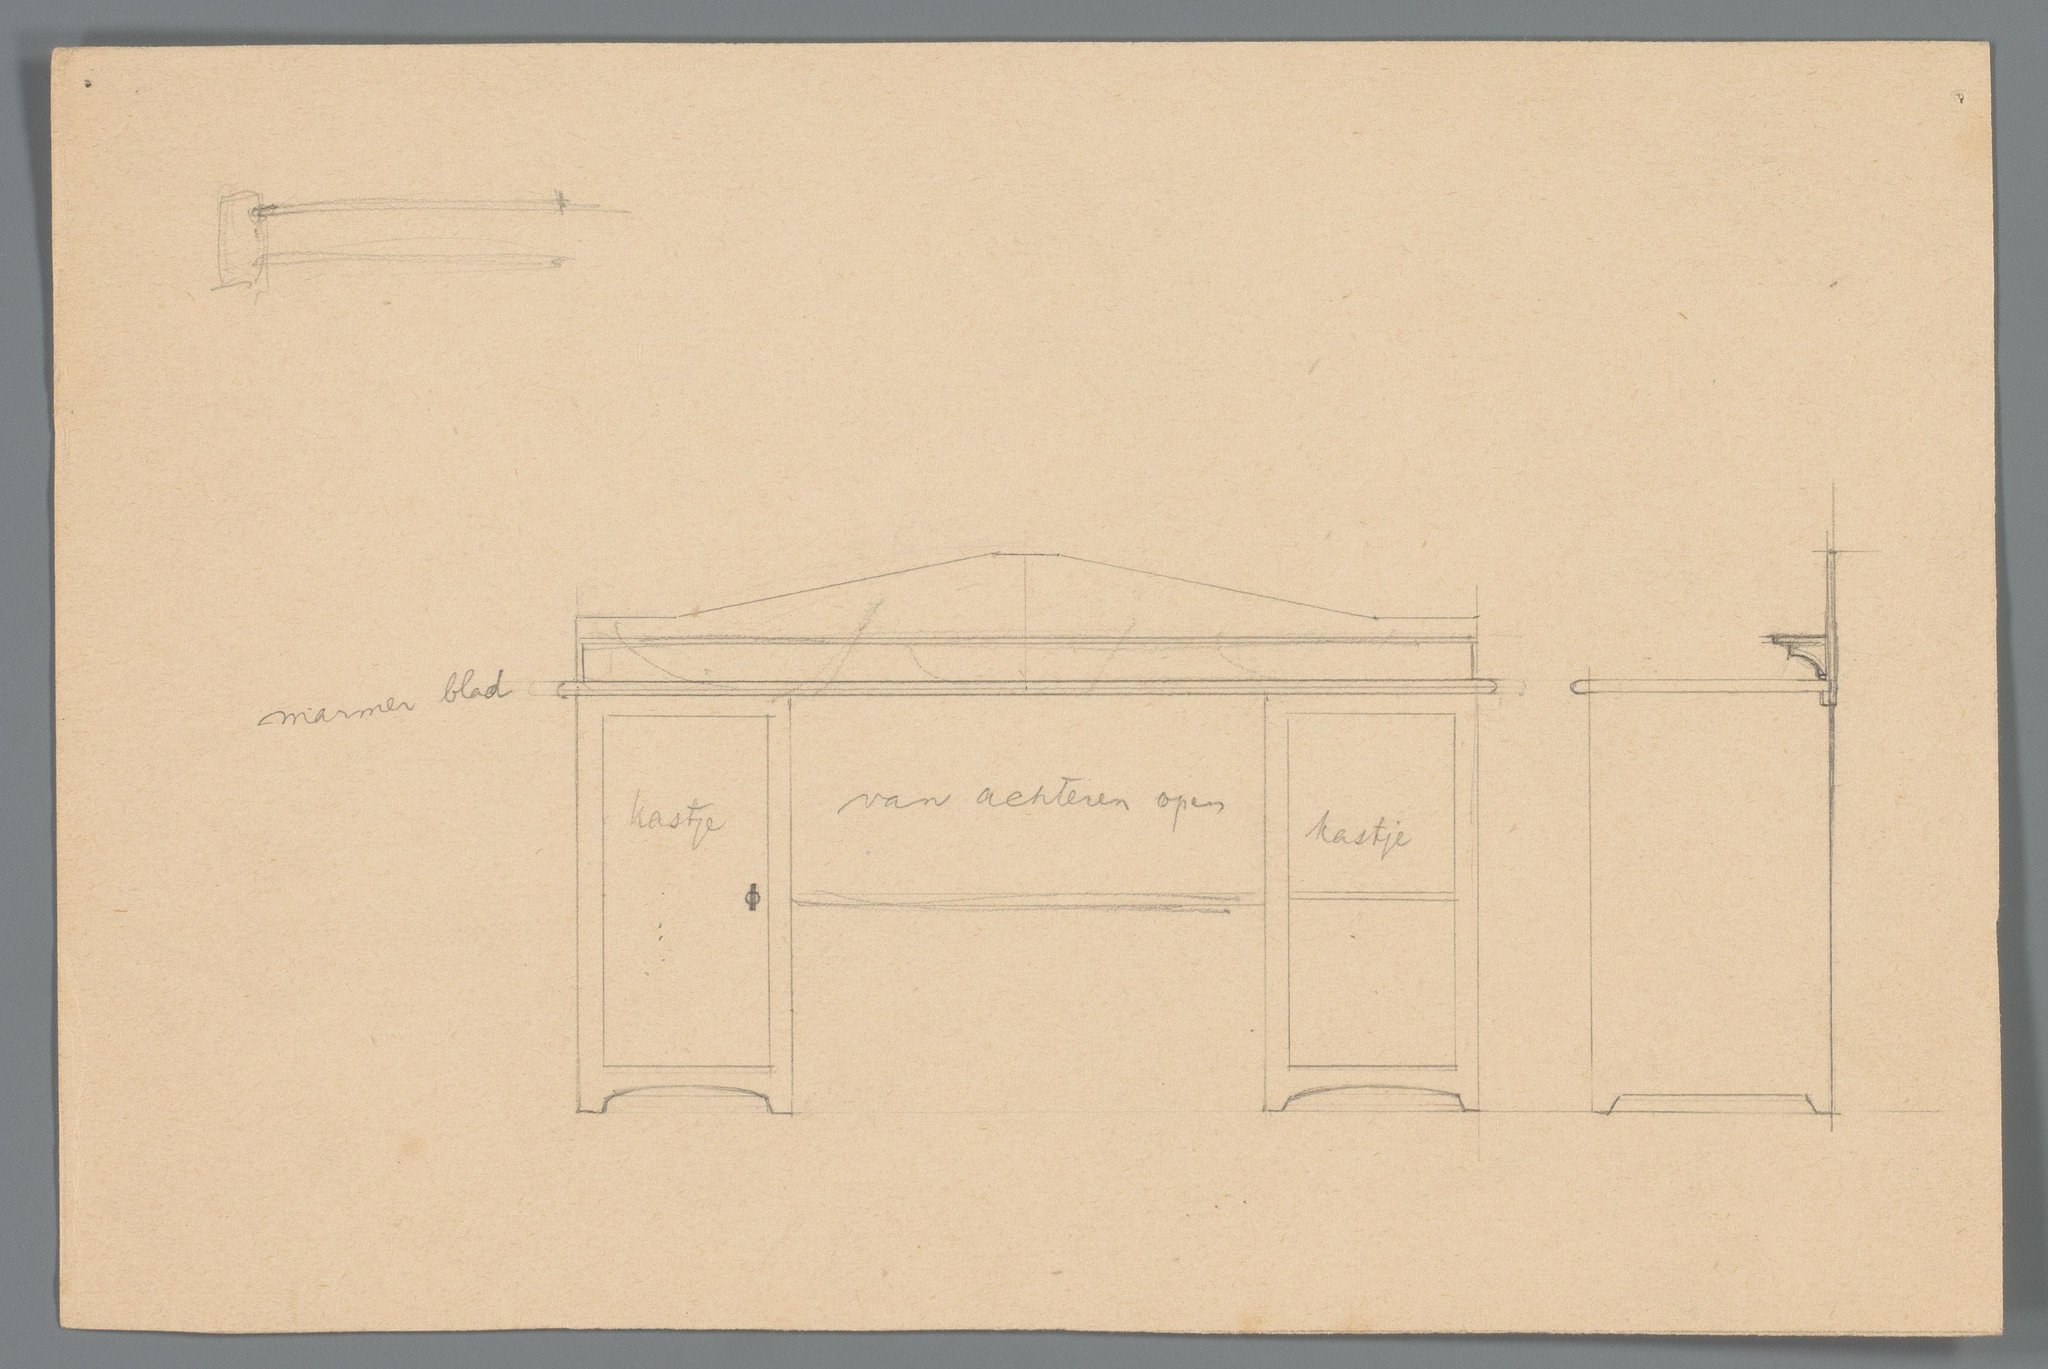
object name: design drawing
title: Ontwerp voor een bureau of lage kast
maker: gust van de wall perné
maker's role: draughtsman, painter, print maker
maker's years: 1877-1911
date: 1887-1911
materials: paper, pencil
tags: writing-table, writing-desk, furniture to put things on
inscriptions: collector's mark: Lugt 2228